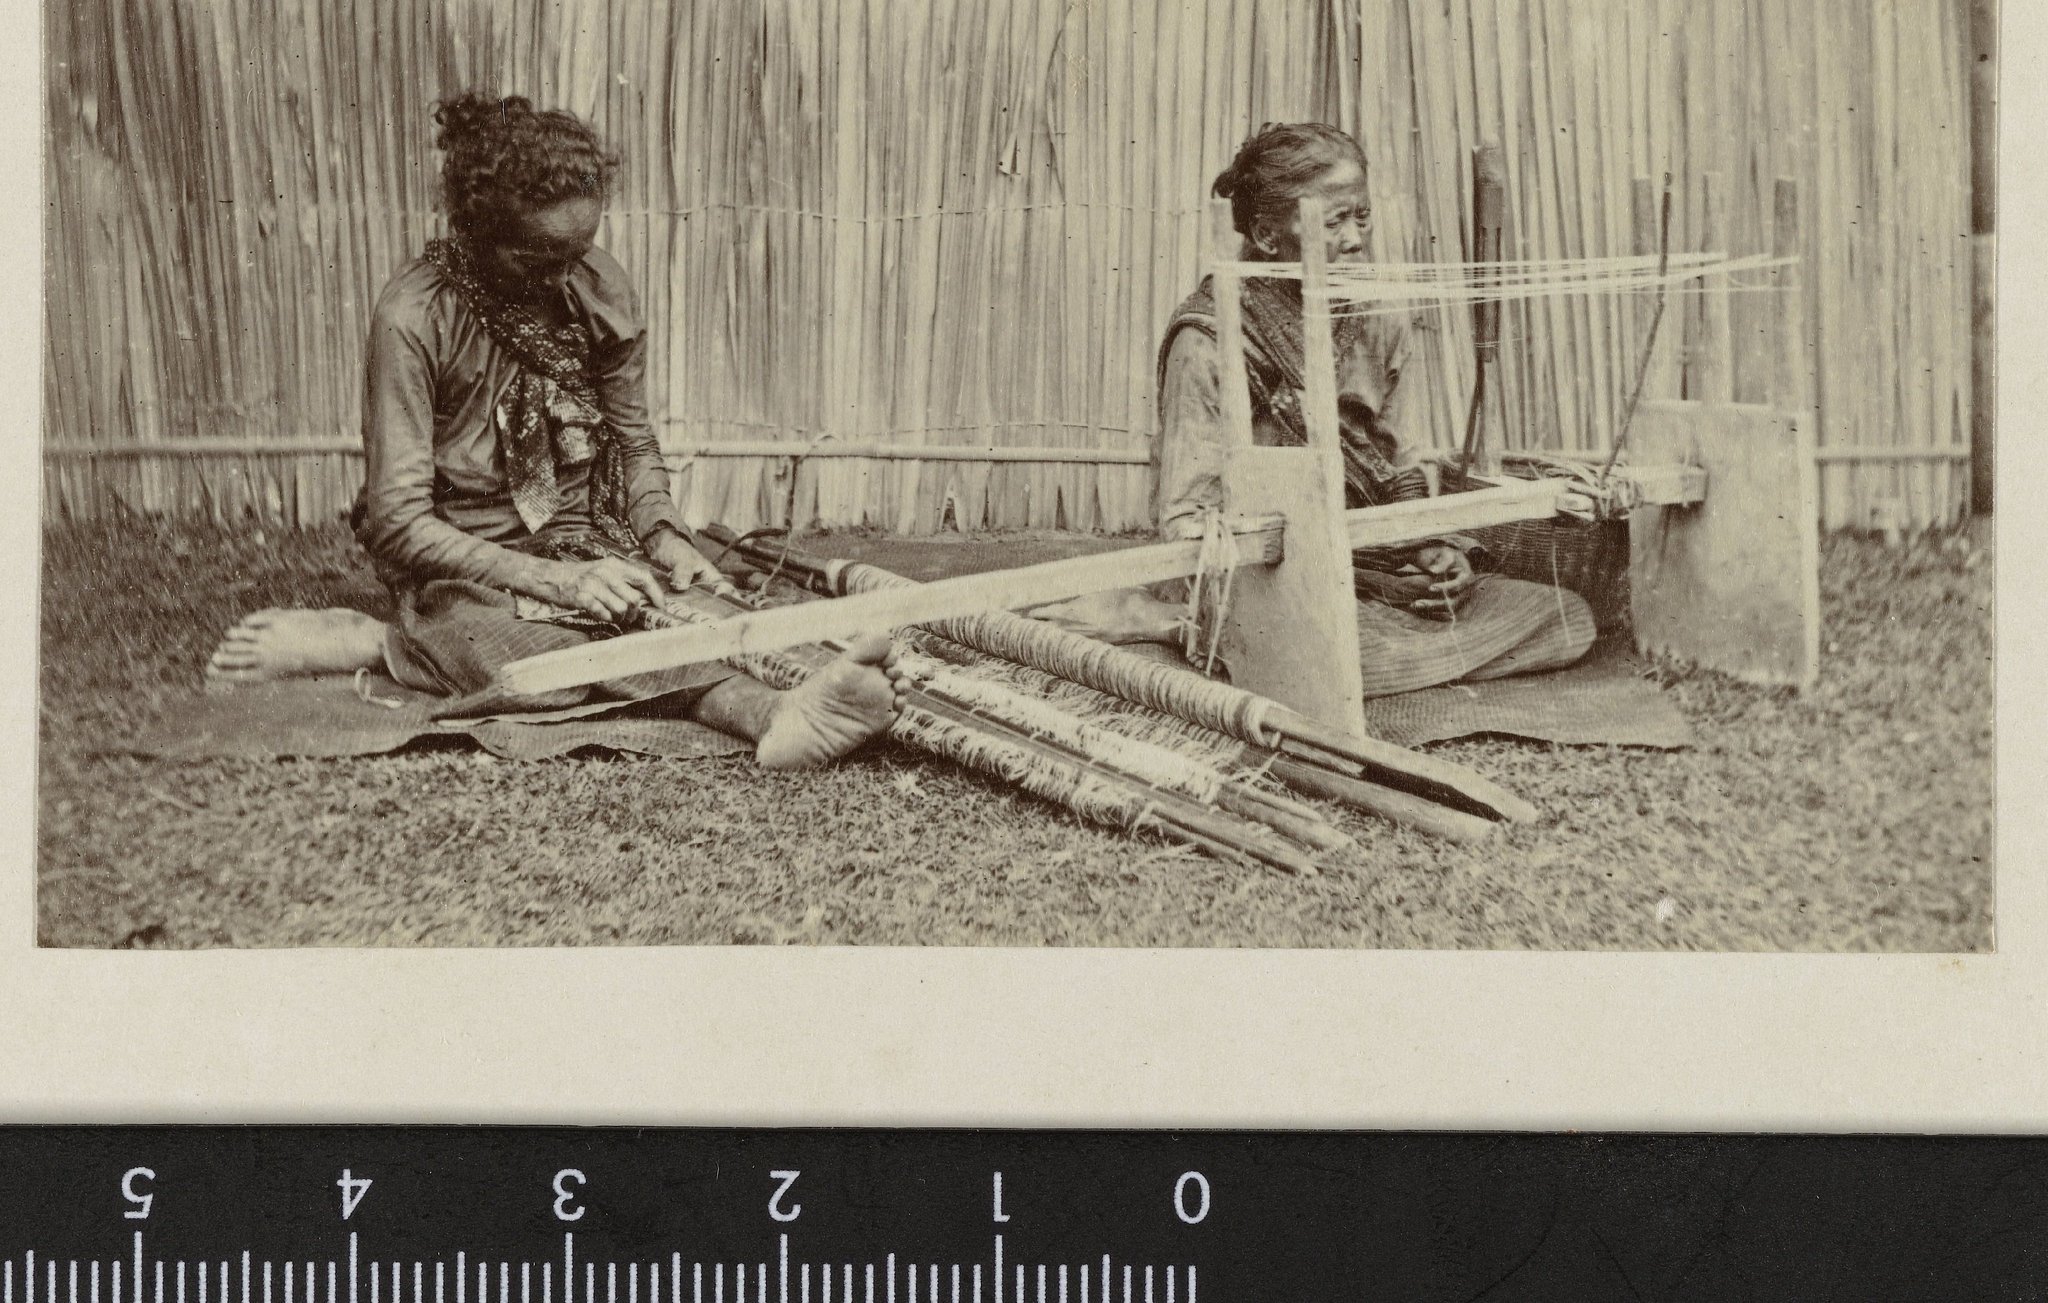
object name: photograph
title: Twee vrouwen aan een weefgetouw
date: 1860-1890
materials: photographic support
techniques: albumen print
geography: batavia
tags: weaving-loom (+ women (labourers)), java, batavia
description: Twee vrouwen aan een weefgetouw, waarschijnlijk op Java. Ingeplakte foto in het fotoalbum getiteld: Gezichten van Java.